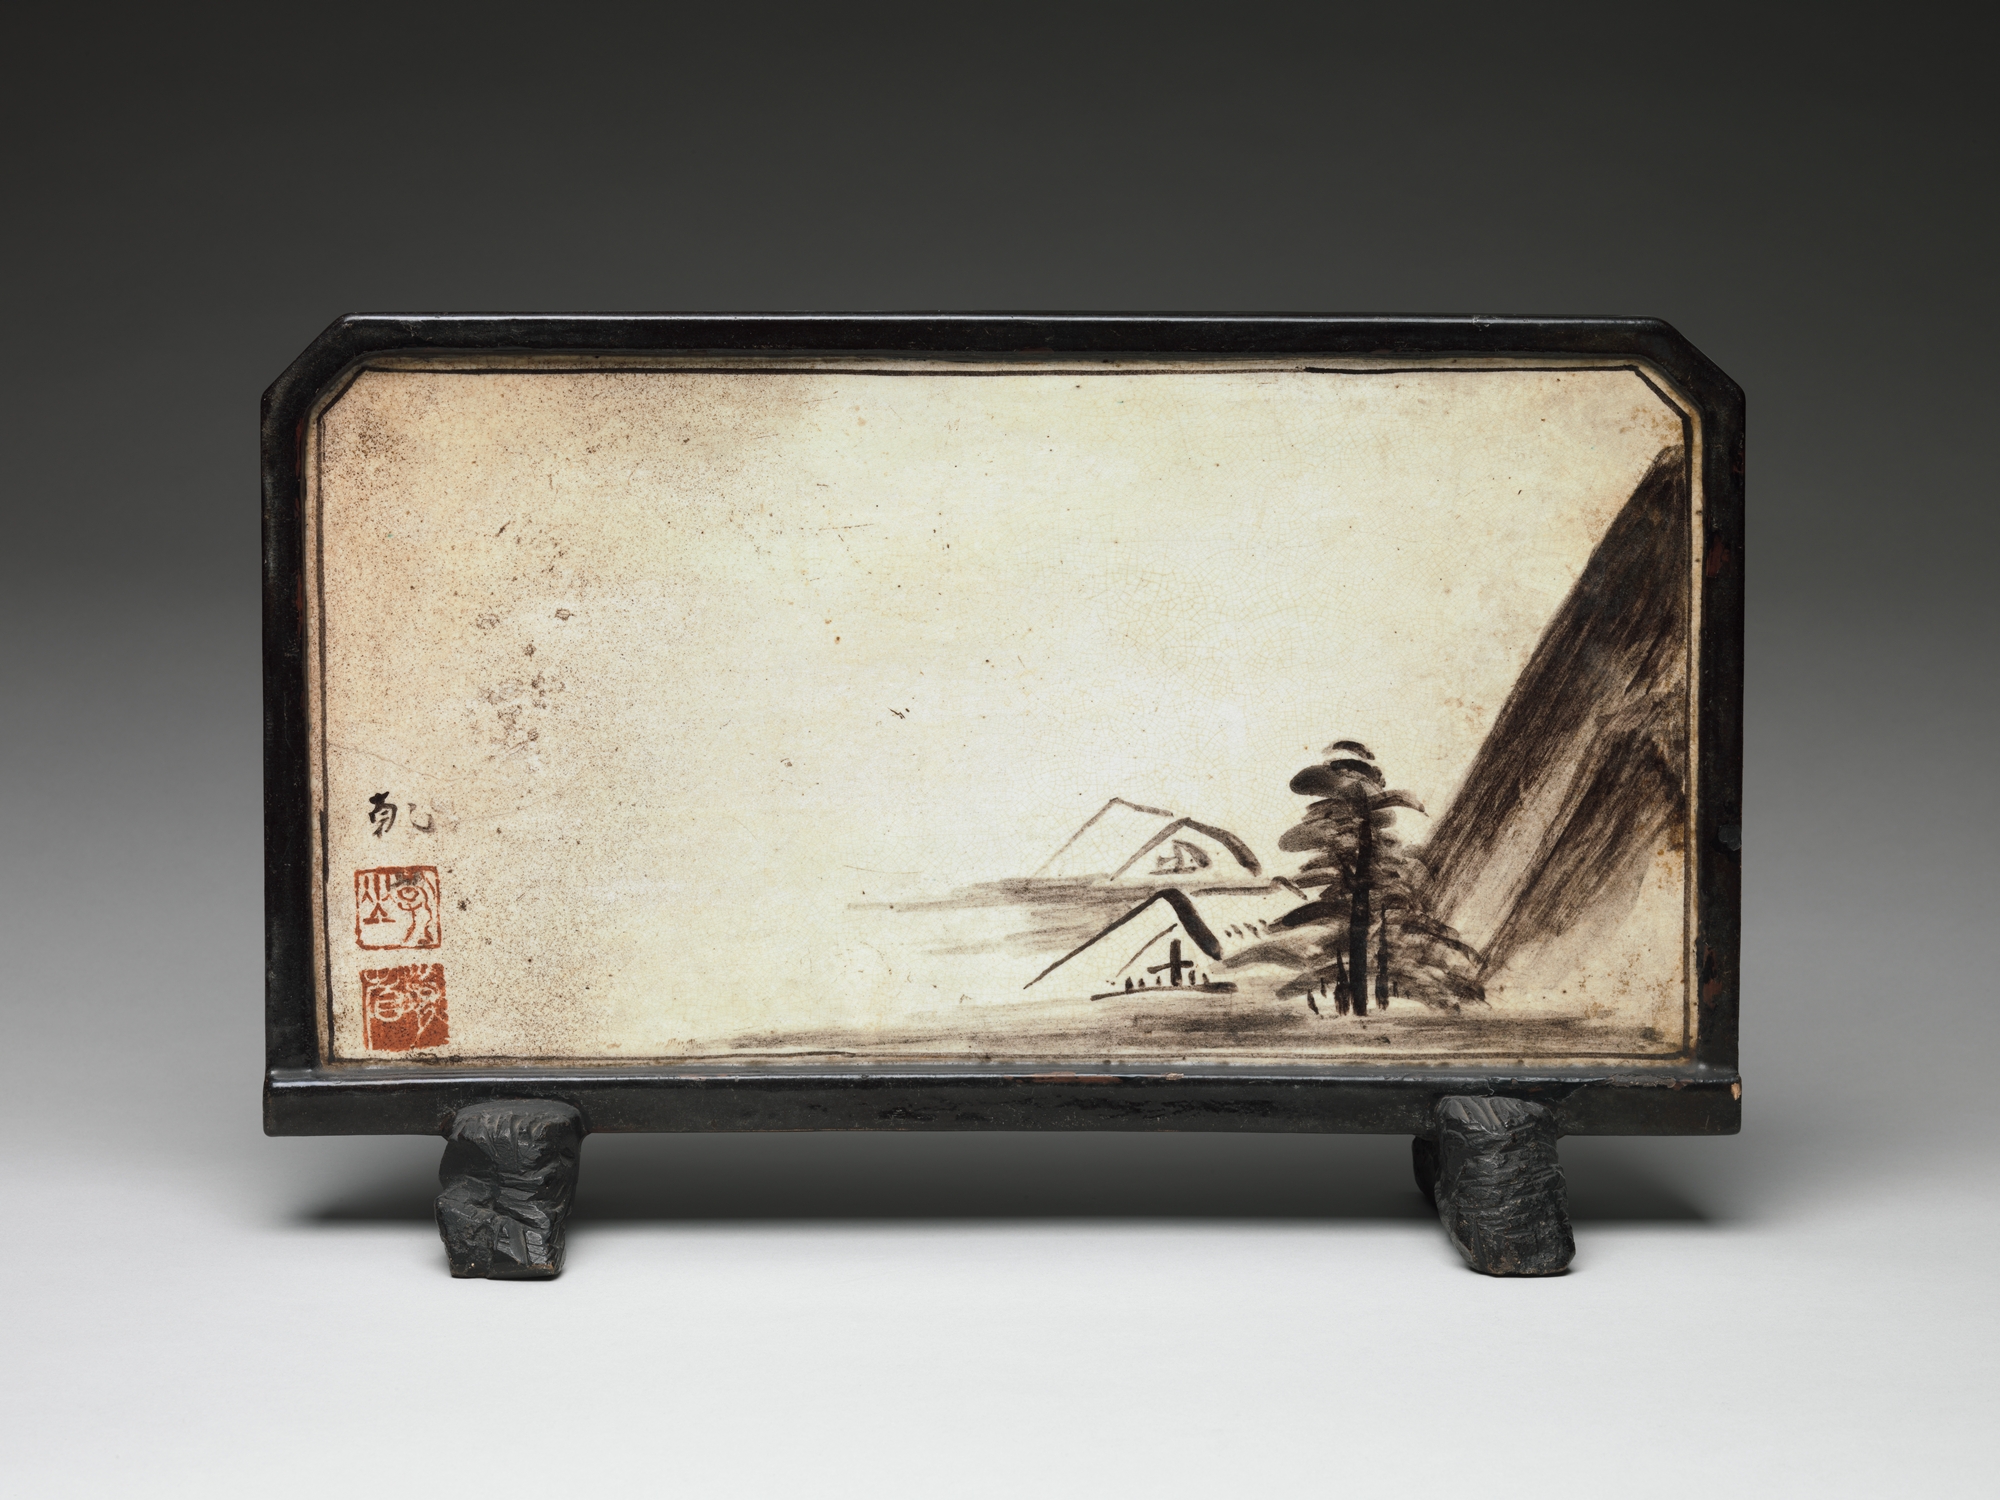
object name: reading screen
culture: japanese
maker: ogata kenzan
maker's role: artist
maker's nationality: japanese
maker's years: 1663-1743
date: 1740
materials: clay, glaze, ivory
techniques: glazing, molding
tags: trees